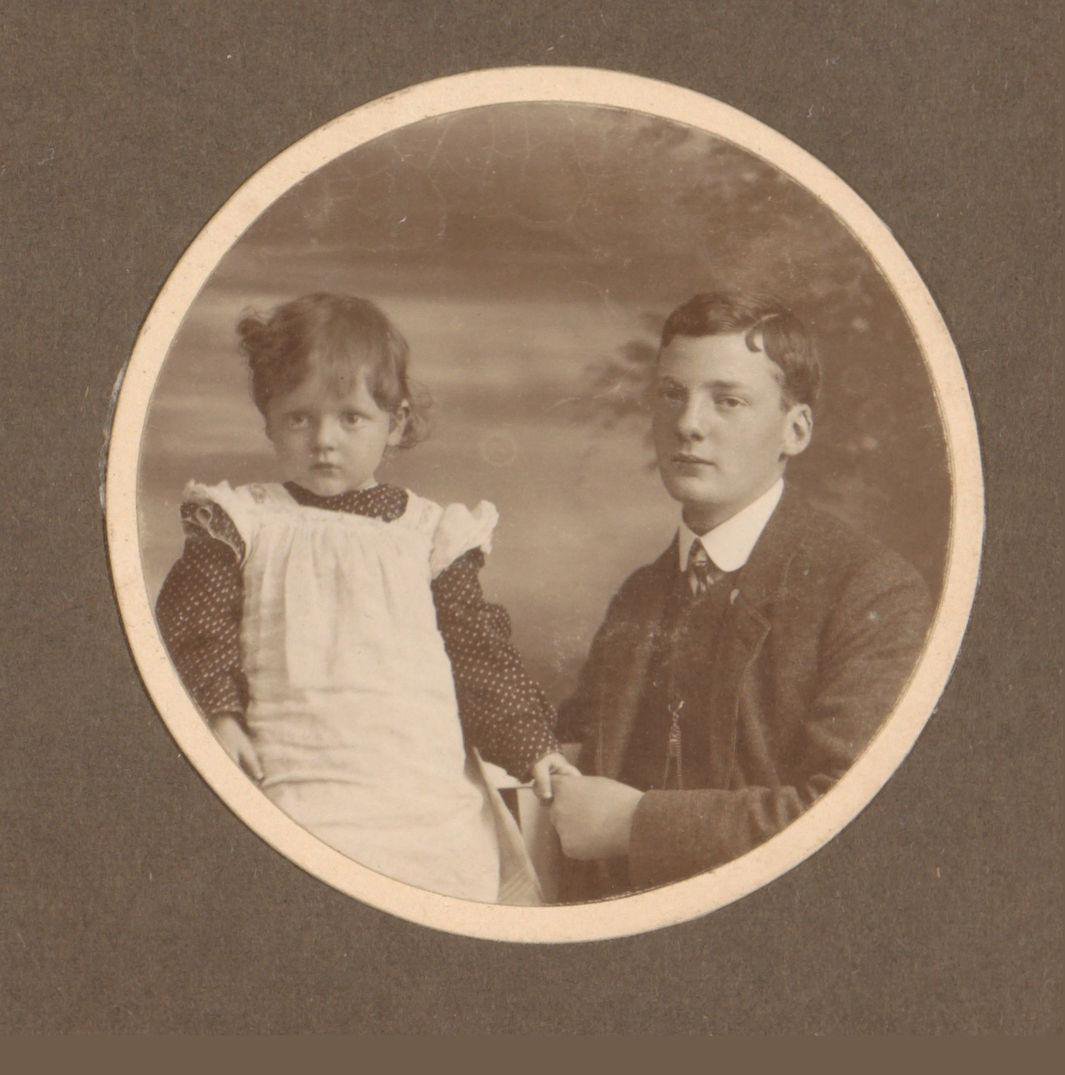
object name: photograph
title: Portret van twee kinderen Vermeulen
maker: cornelis johannes lodewicus vermeulen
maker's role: fotograaf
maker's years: 1861-1936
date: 1900-1920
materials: paper, photographic support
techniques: gelatin silver print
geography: the hague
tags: studio requisites ~ photographer, brothers or sisters (second degree family relationships), the hague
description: Onderdeel van Fotoalbum met opnames van het gezin en het huis van fotograaf C.J.L. Vermeulen in Den Haag.